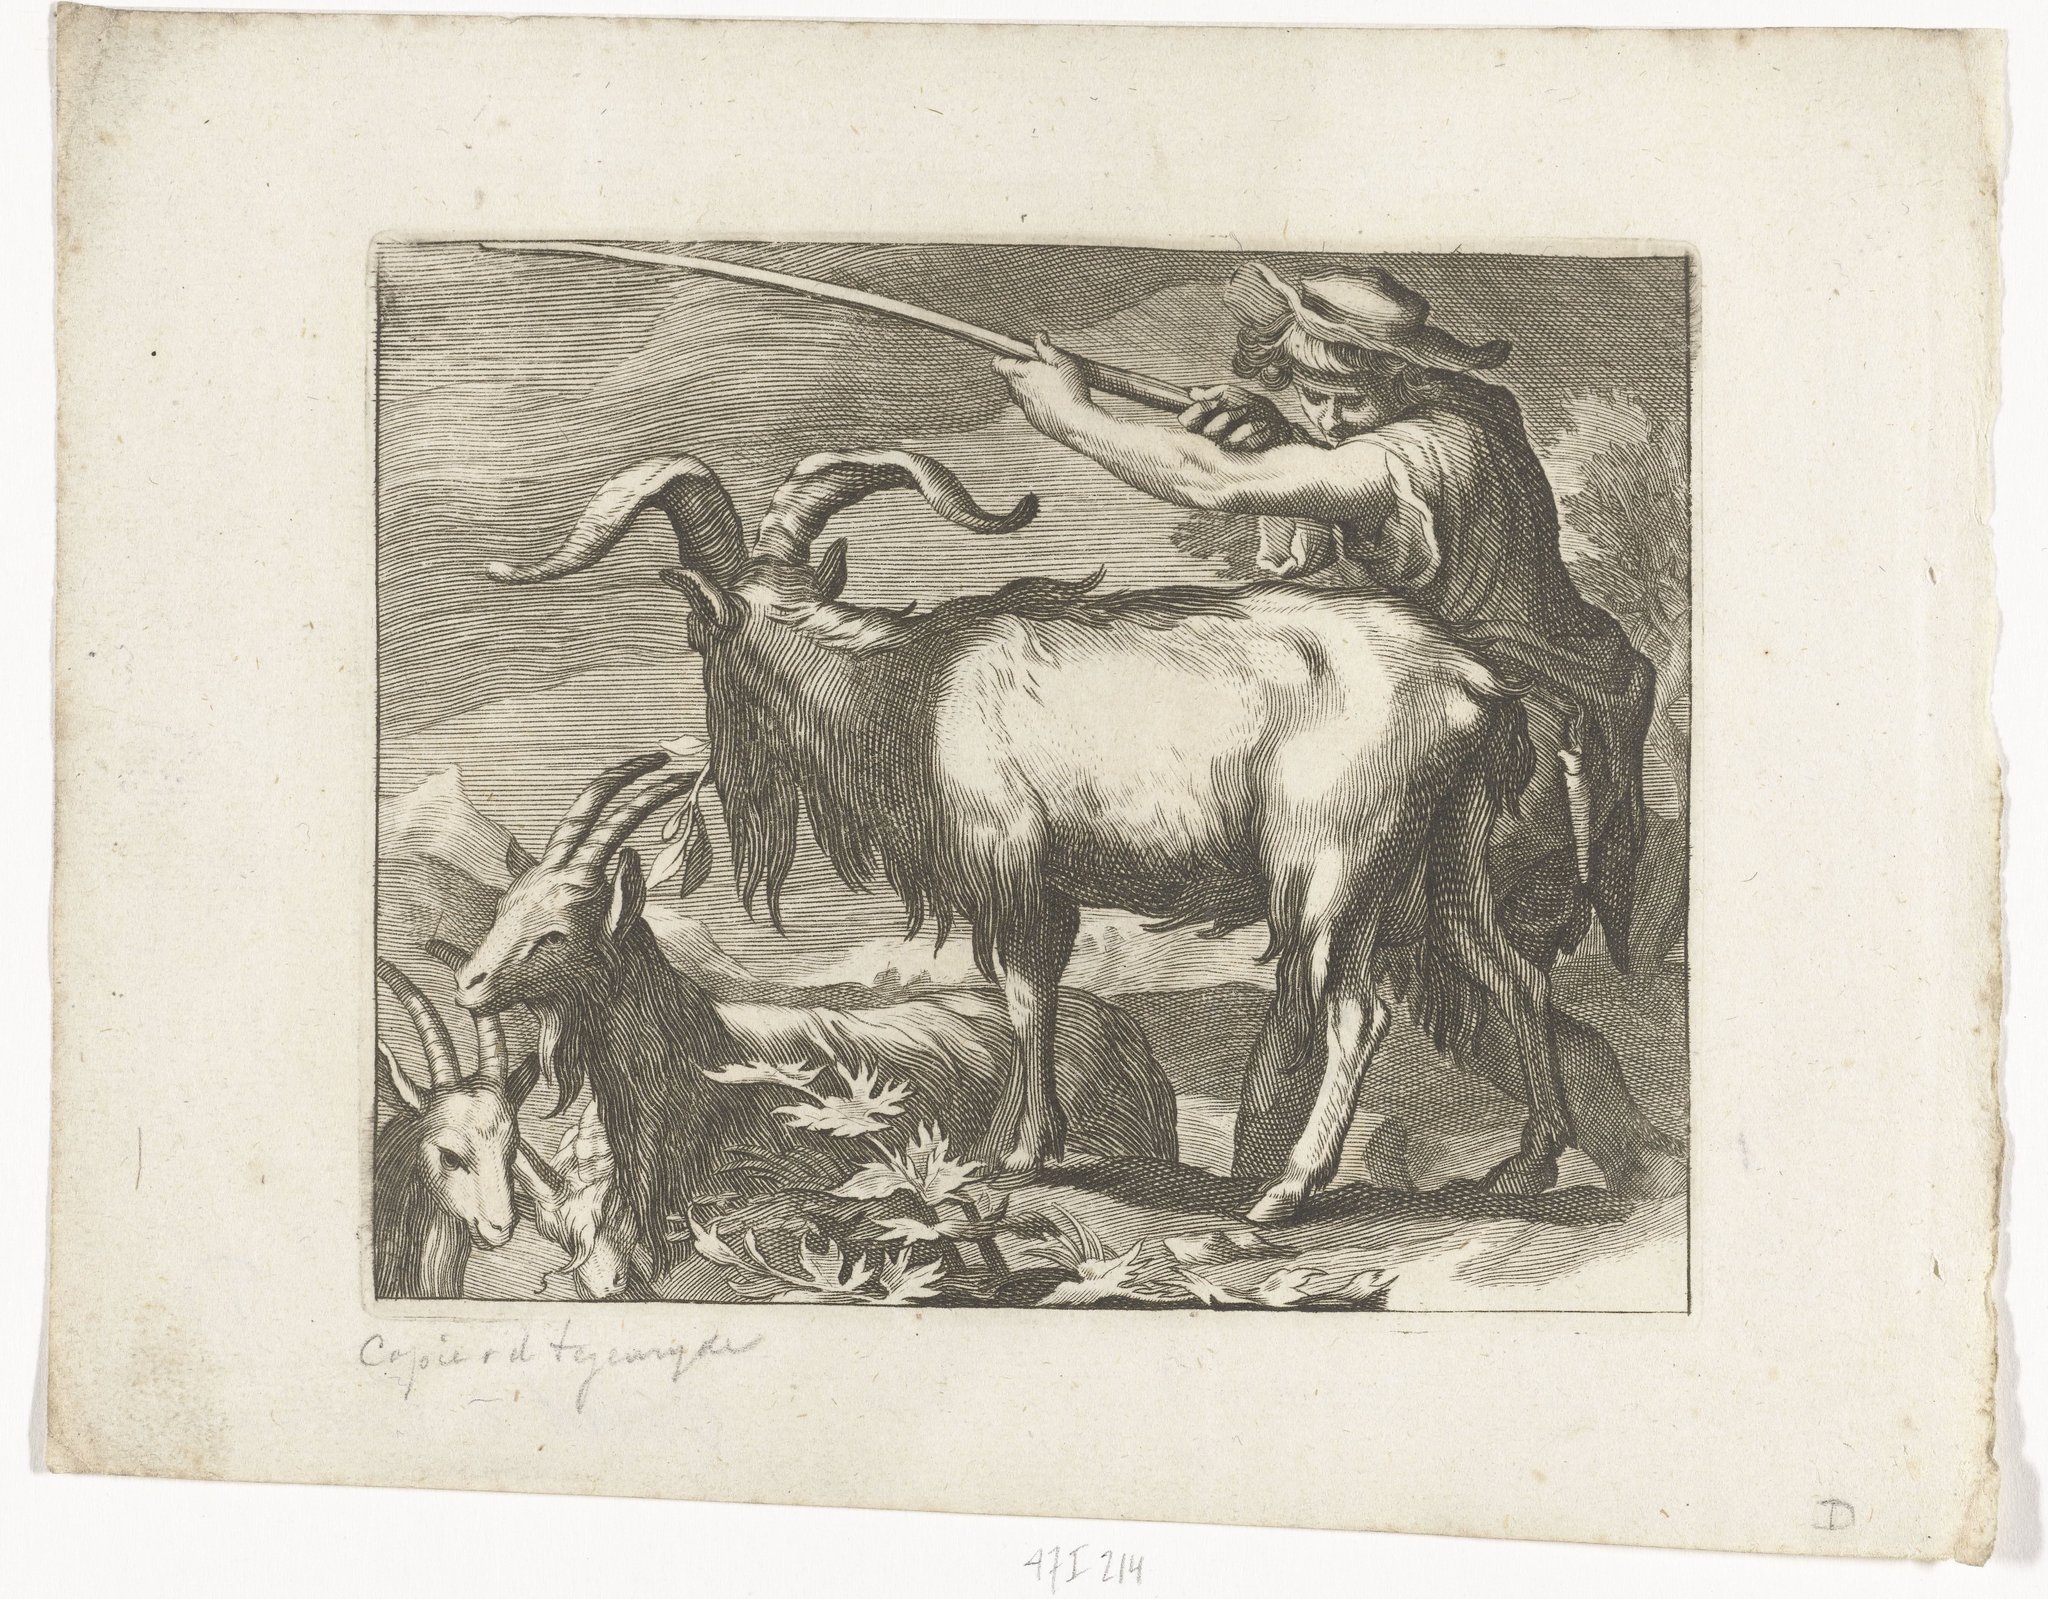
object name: print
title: Pastoralen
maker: Anonymous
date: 1611-1661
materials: paper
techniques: engraving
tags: herding, herdsman, herdswoman, shepherd, shepherdess, cowherd, etc., goat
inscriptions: collector's mark: Lugt 2228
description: Kopie in spiegelbeeld naar prent uit serie met veertien prenten zogenaamde Pastoralen van B.A. Bolswert naar ontwerp van Abraham Bloemaert.